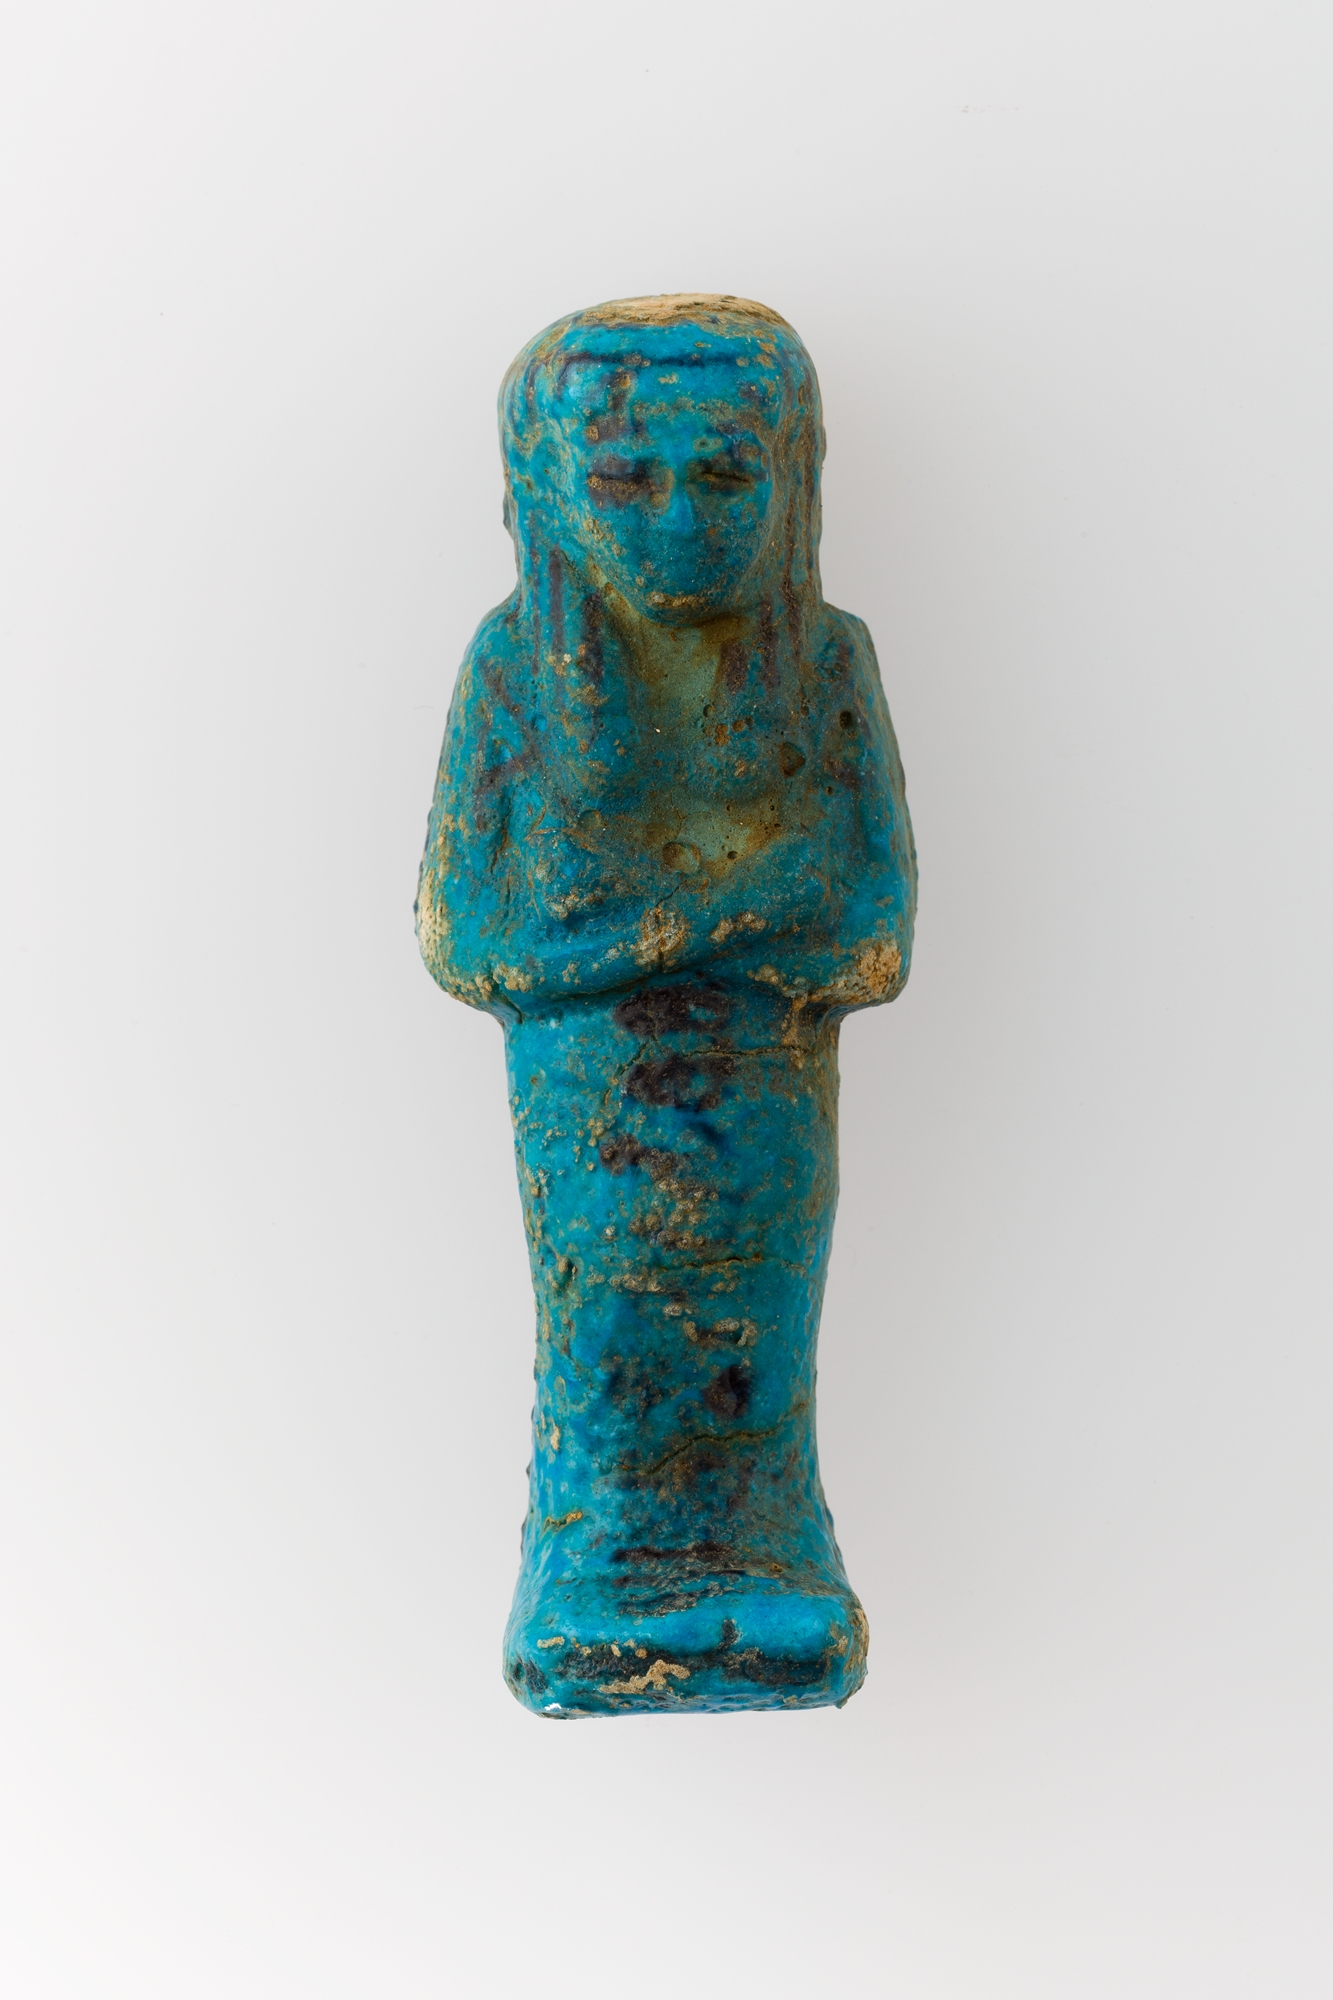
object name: shabti, henettawy c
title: Worker Shabti of Henettawy (C), Daughter of Isetemkheb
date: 990-970 BCE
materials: faience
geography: egypt